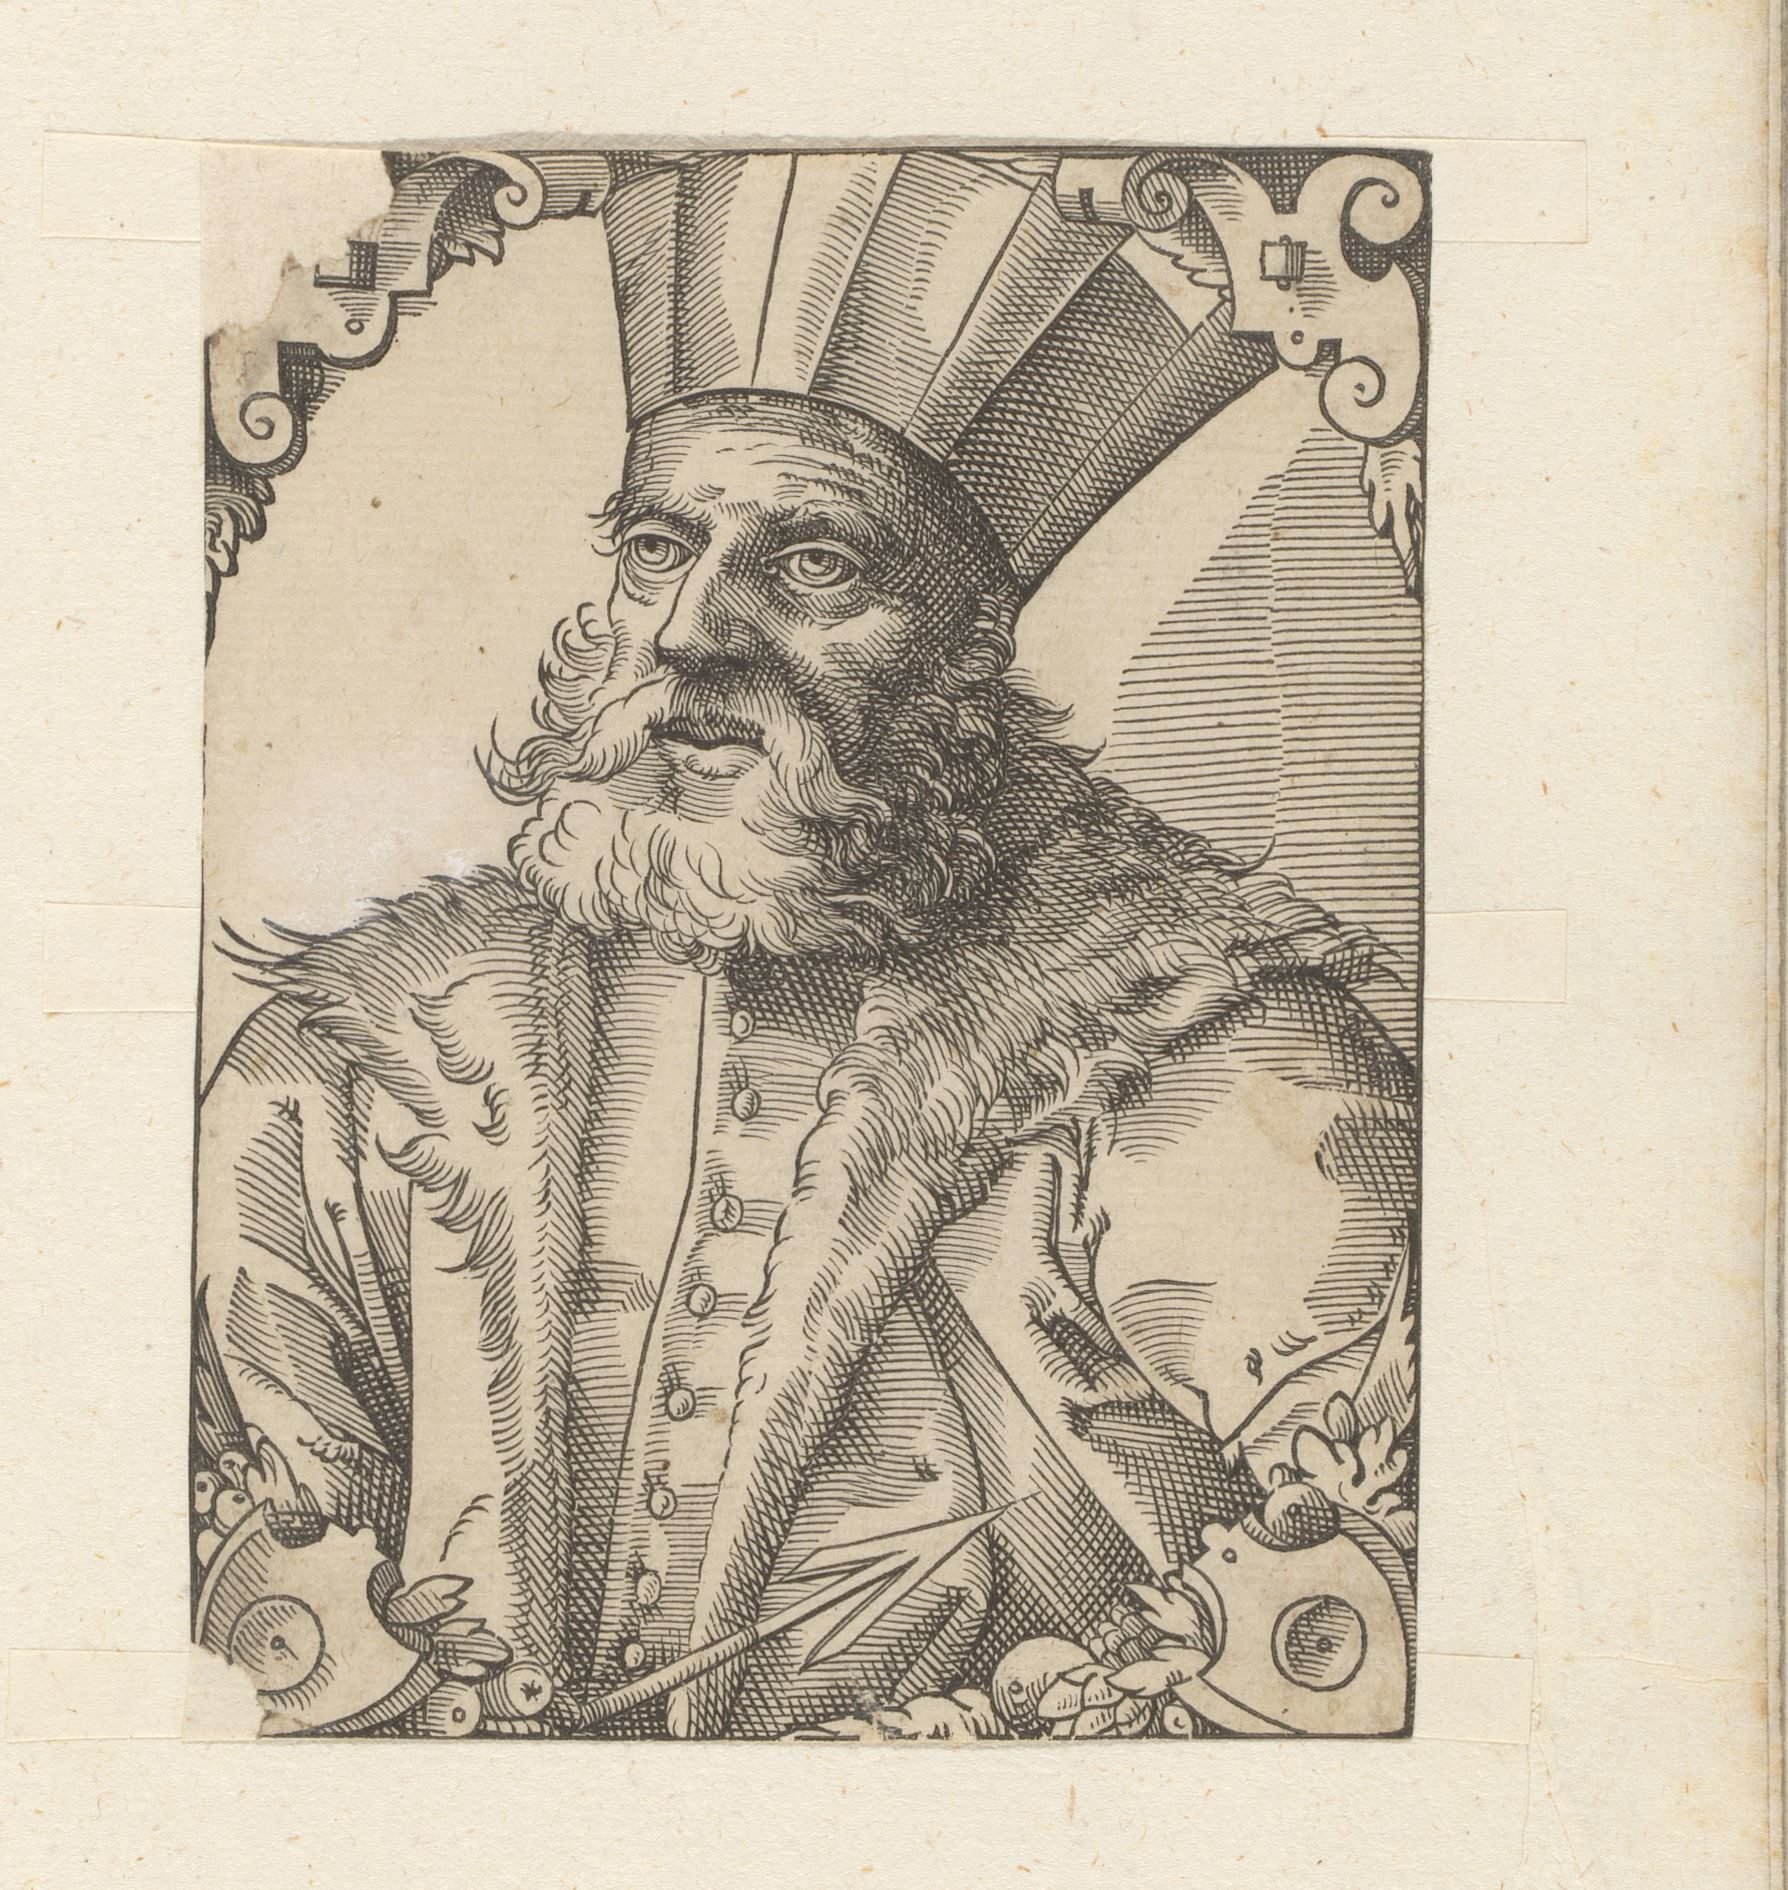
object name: album leaf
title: Portret van Usum Cassan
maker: Anonymous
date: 1549-1577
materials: paper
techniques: woodcut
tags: historical persons, ruler, sovereign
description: Prent gebruikt in: Giovio, Paolo. Musaei Ioviani Imagines (...). Bazel: Peter Perna, 1577.